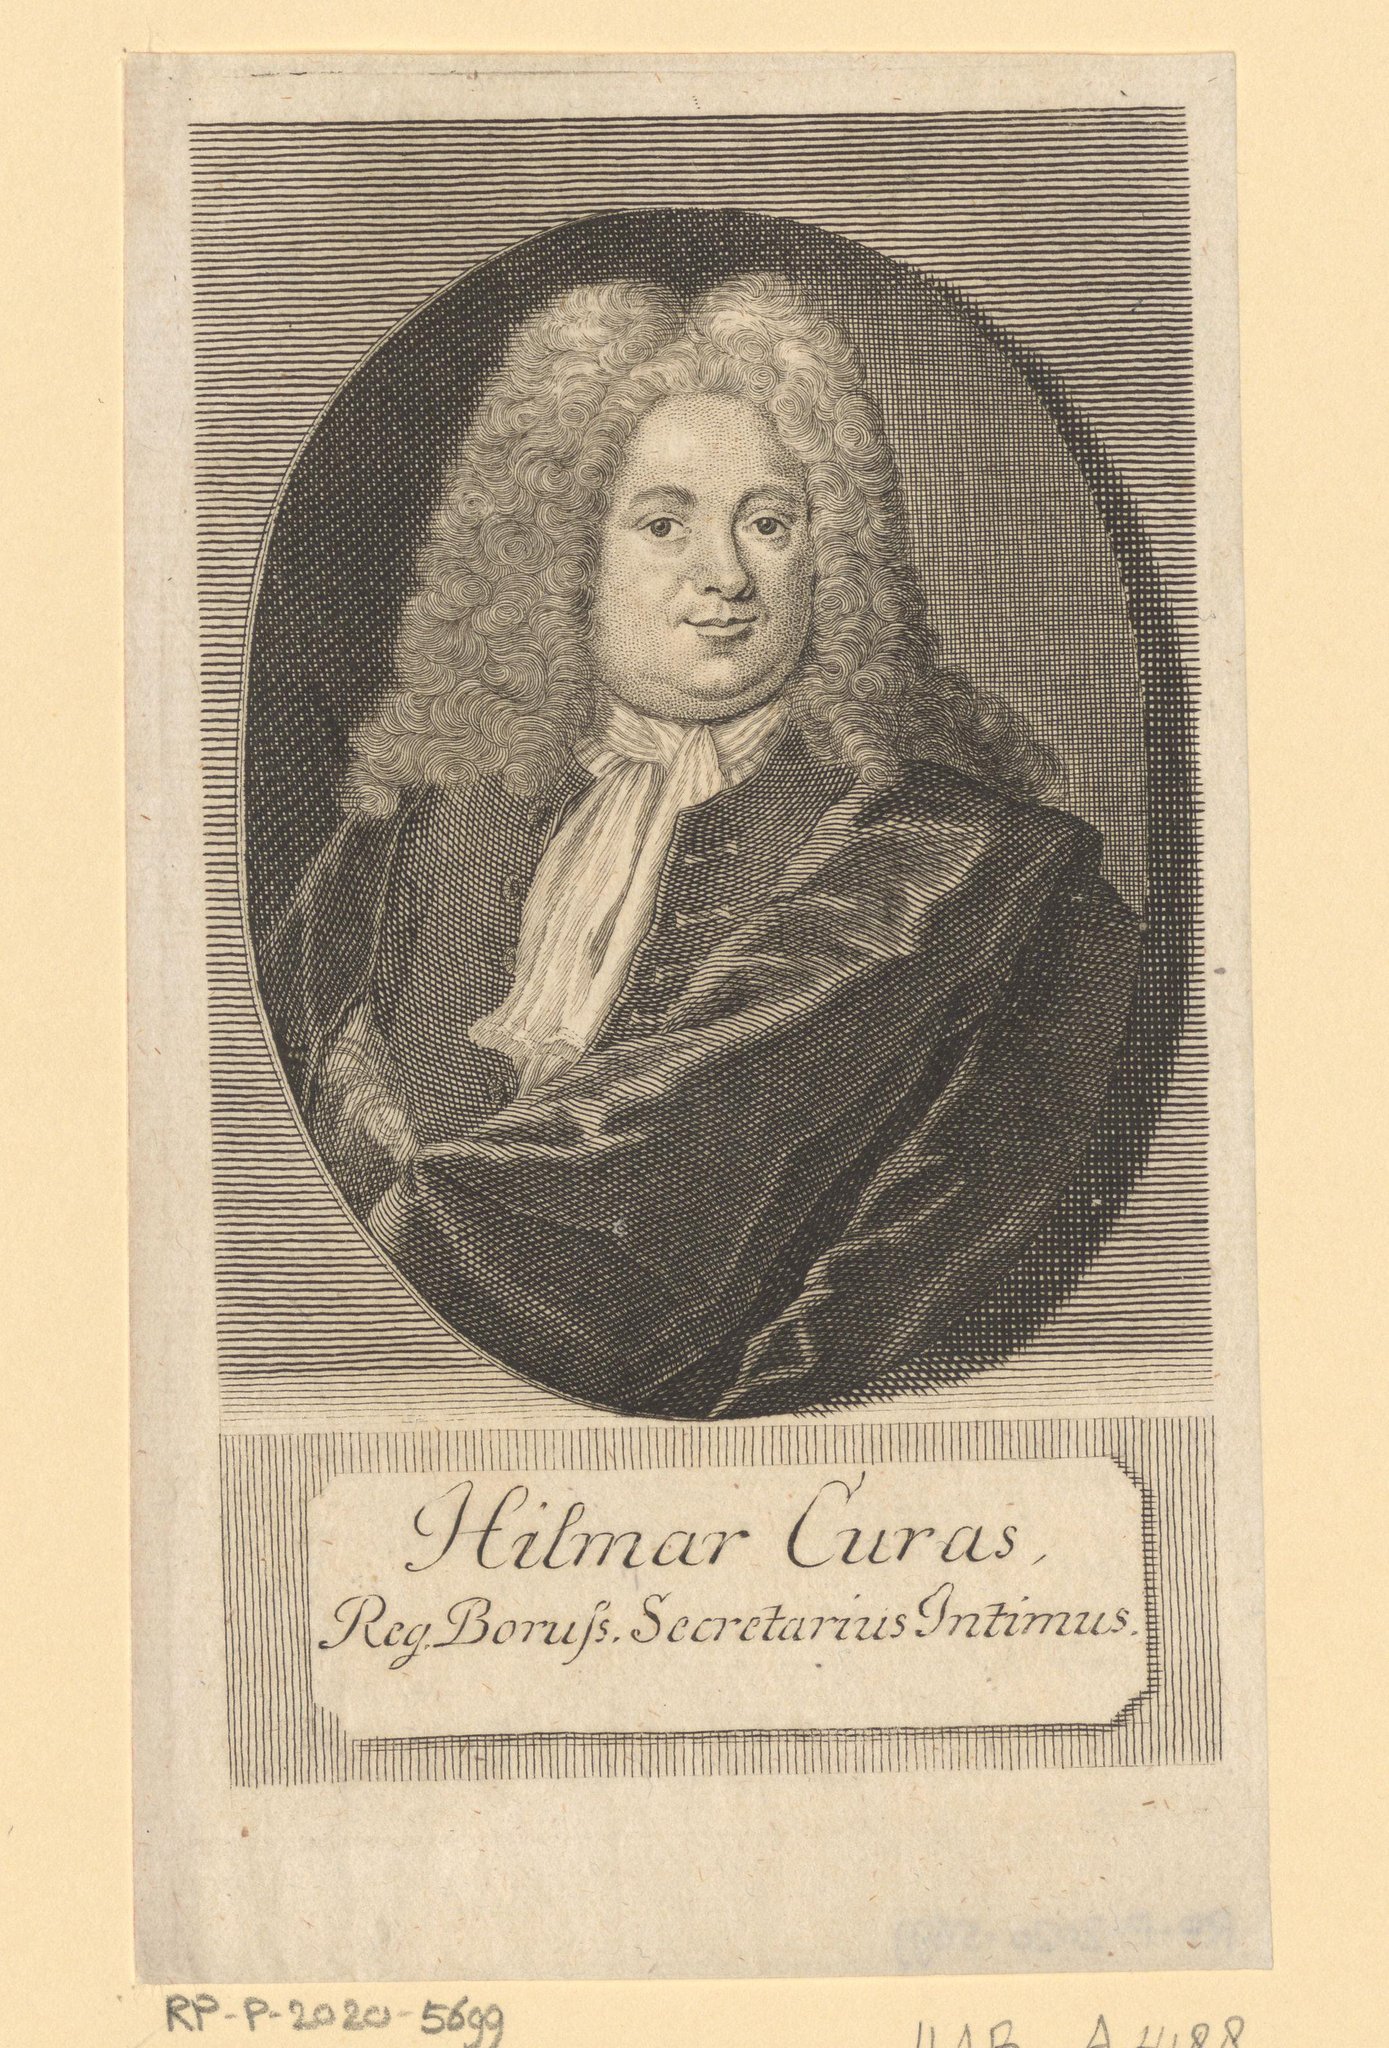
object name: print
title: Portret van Hilmar Curas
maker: martin bernigeroth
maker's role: print maker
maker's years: 1670-1733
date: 1730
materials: paper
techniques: engraving, etching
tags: historical persons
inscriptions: collector's mark: Lugt 2228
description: Prent mogelijk uit: Deutsche Acta Eruditorum. Leipzig: Johann Gottlieb Gleditsch, 1730, dl. 156.